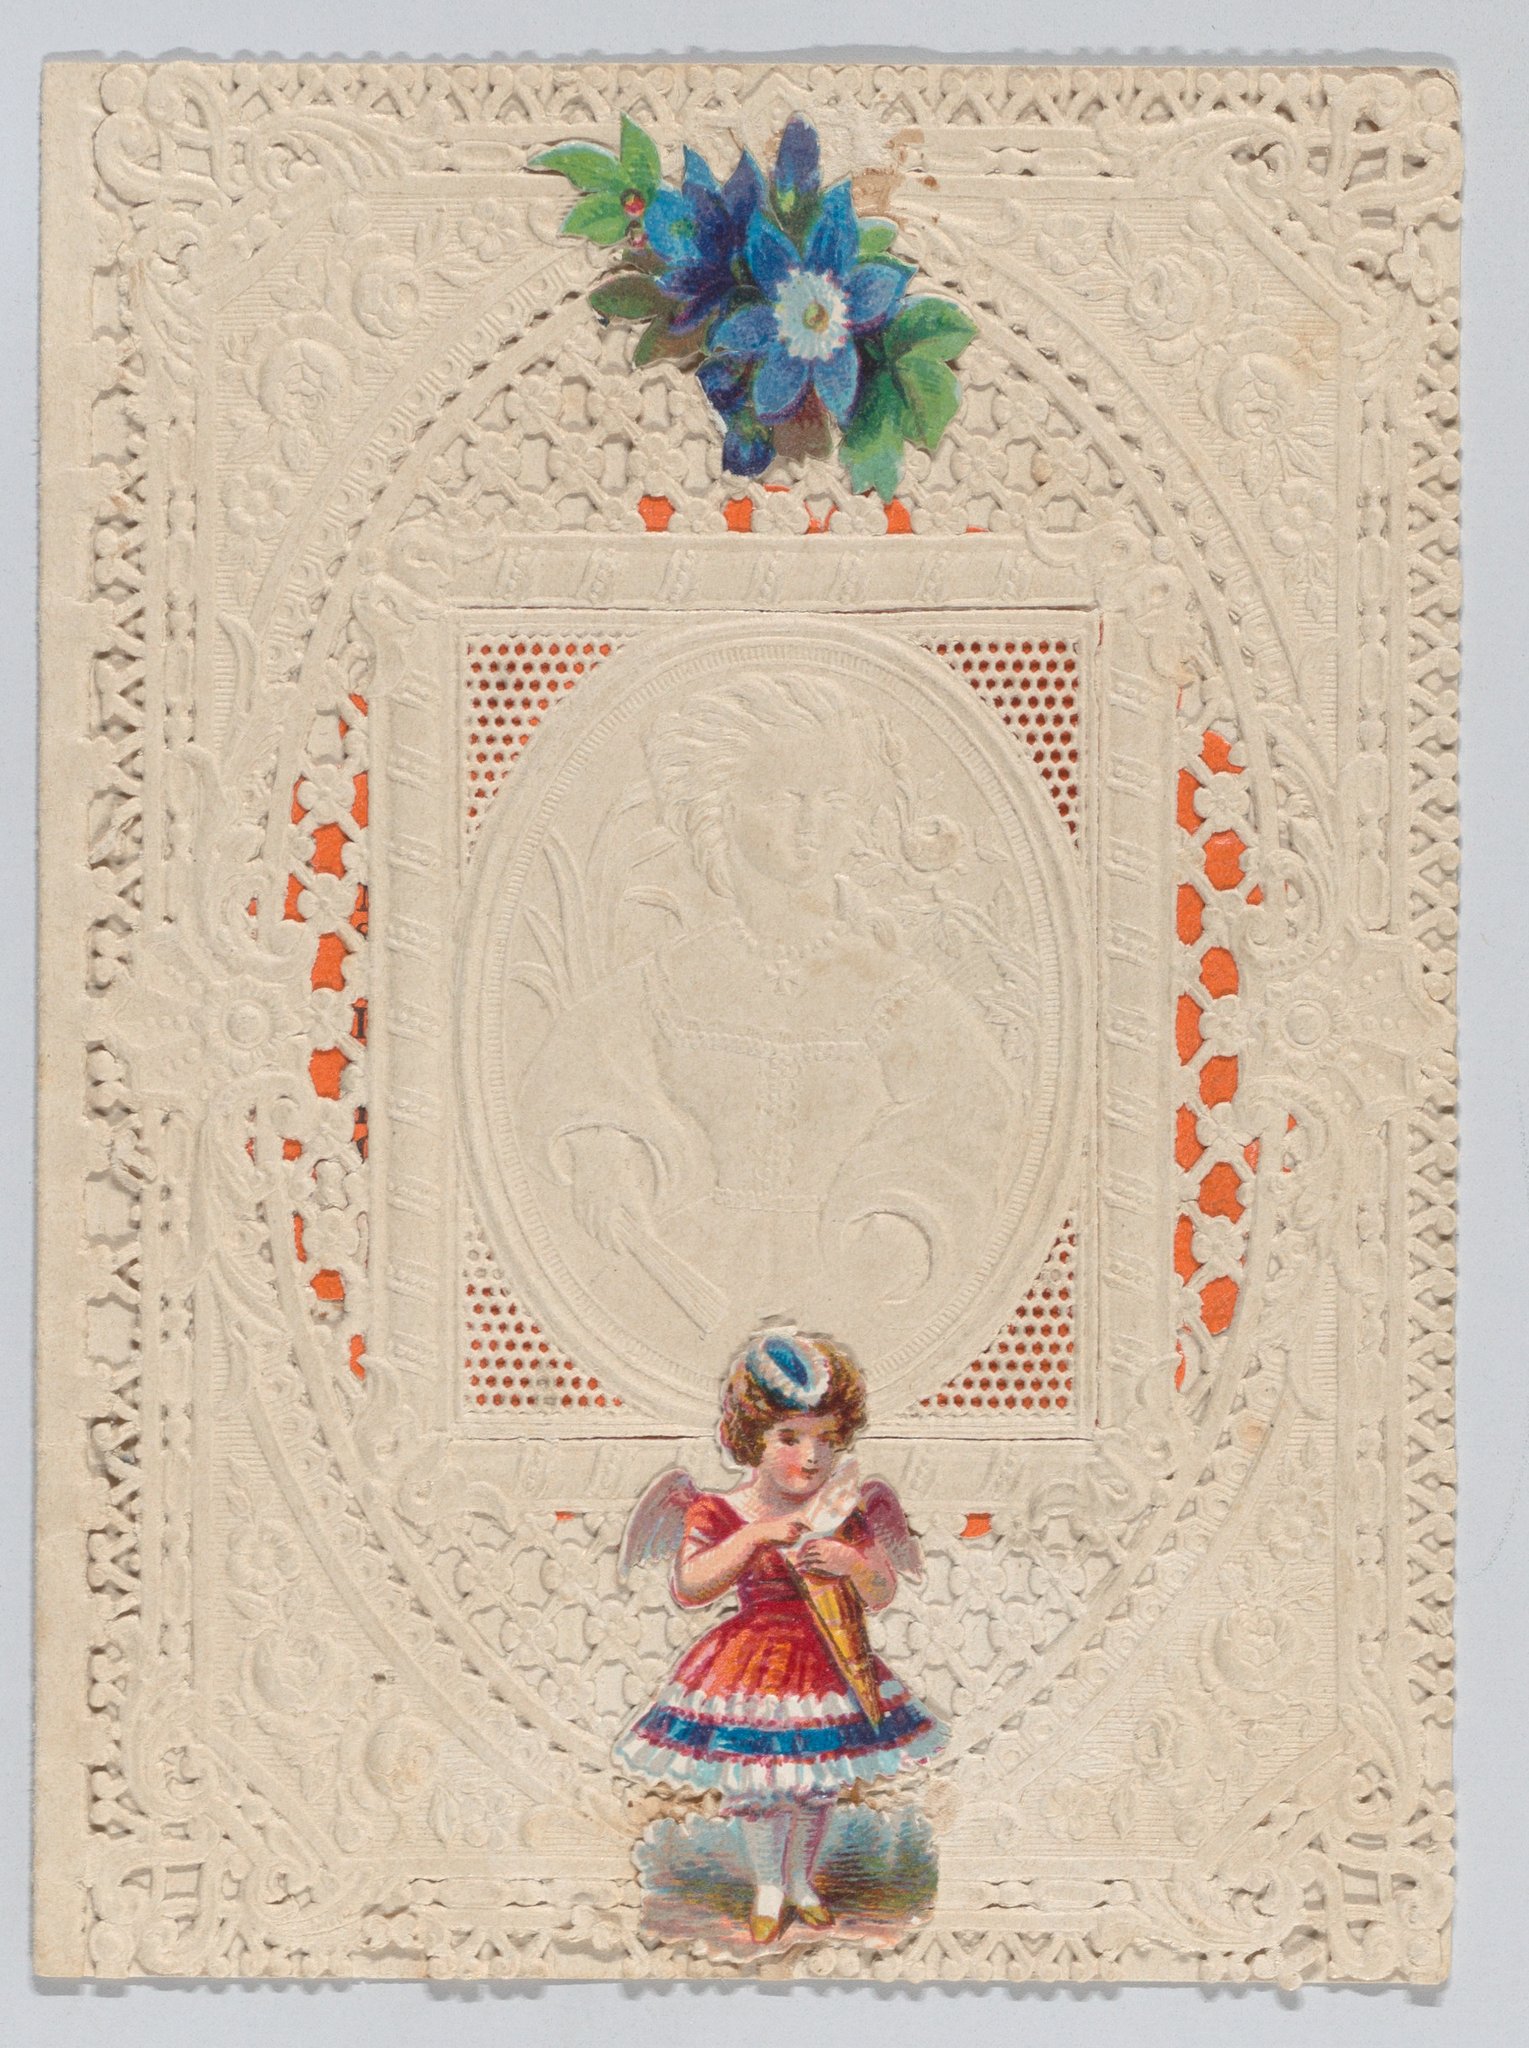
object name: valentine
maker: Anonymous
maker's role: artist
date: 1850-1870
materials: lace, paper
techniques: chromolithography, embossing, open work